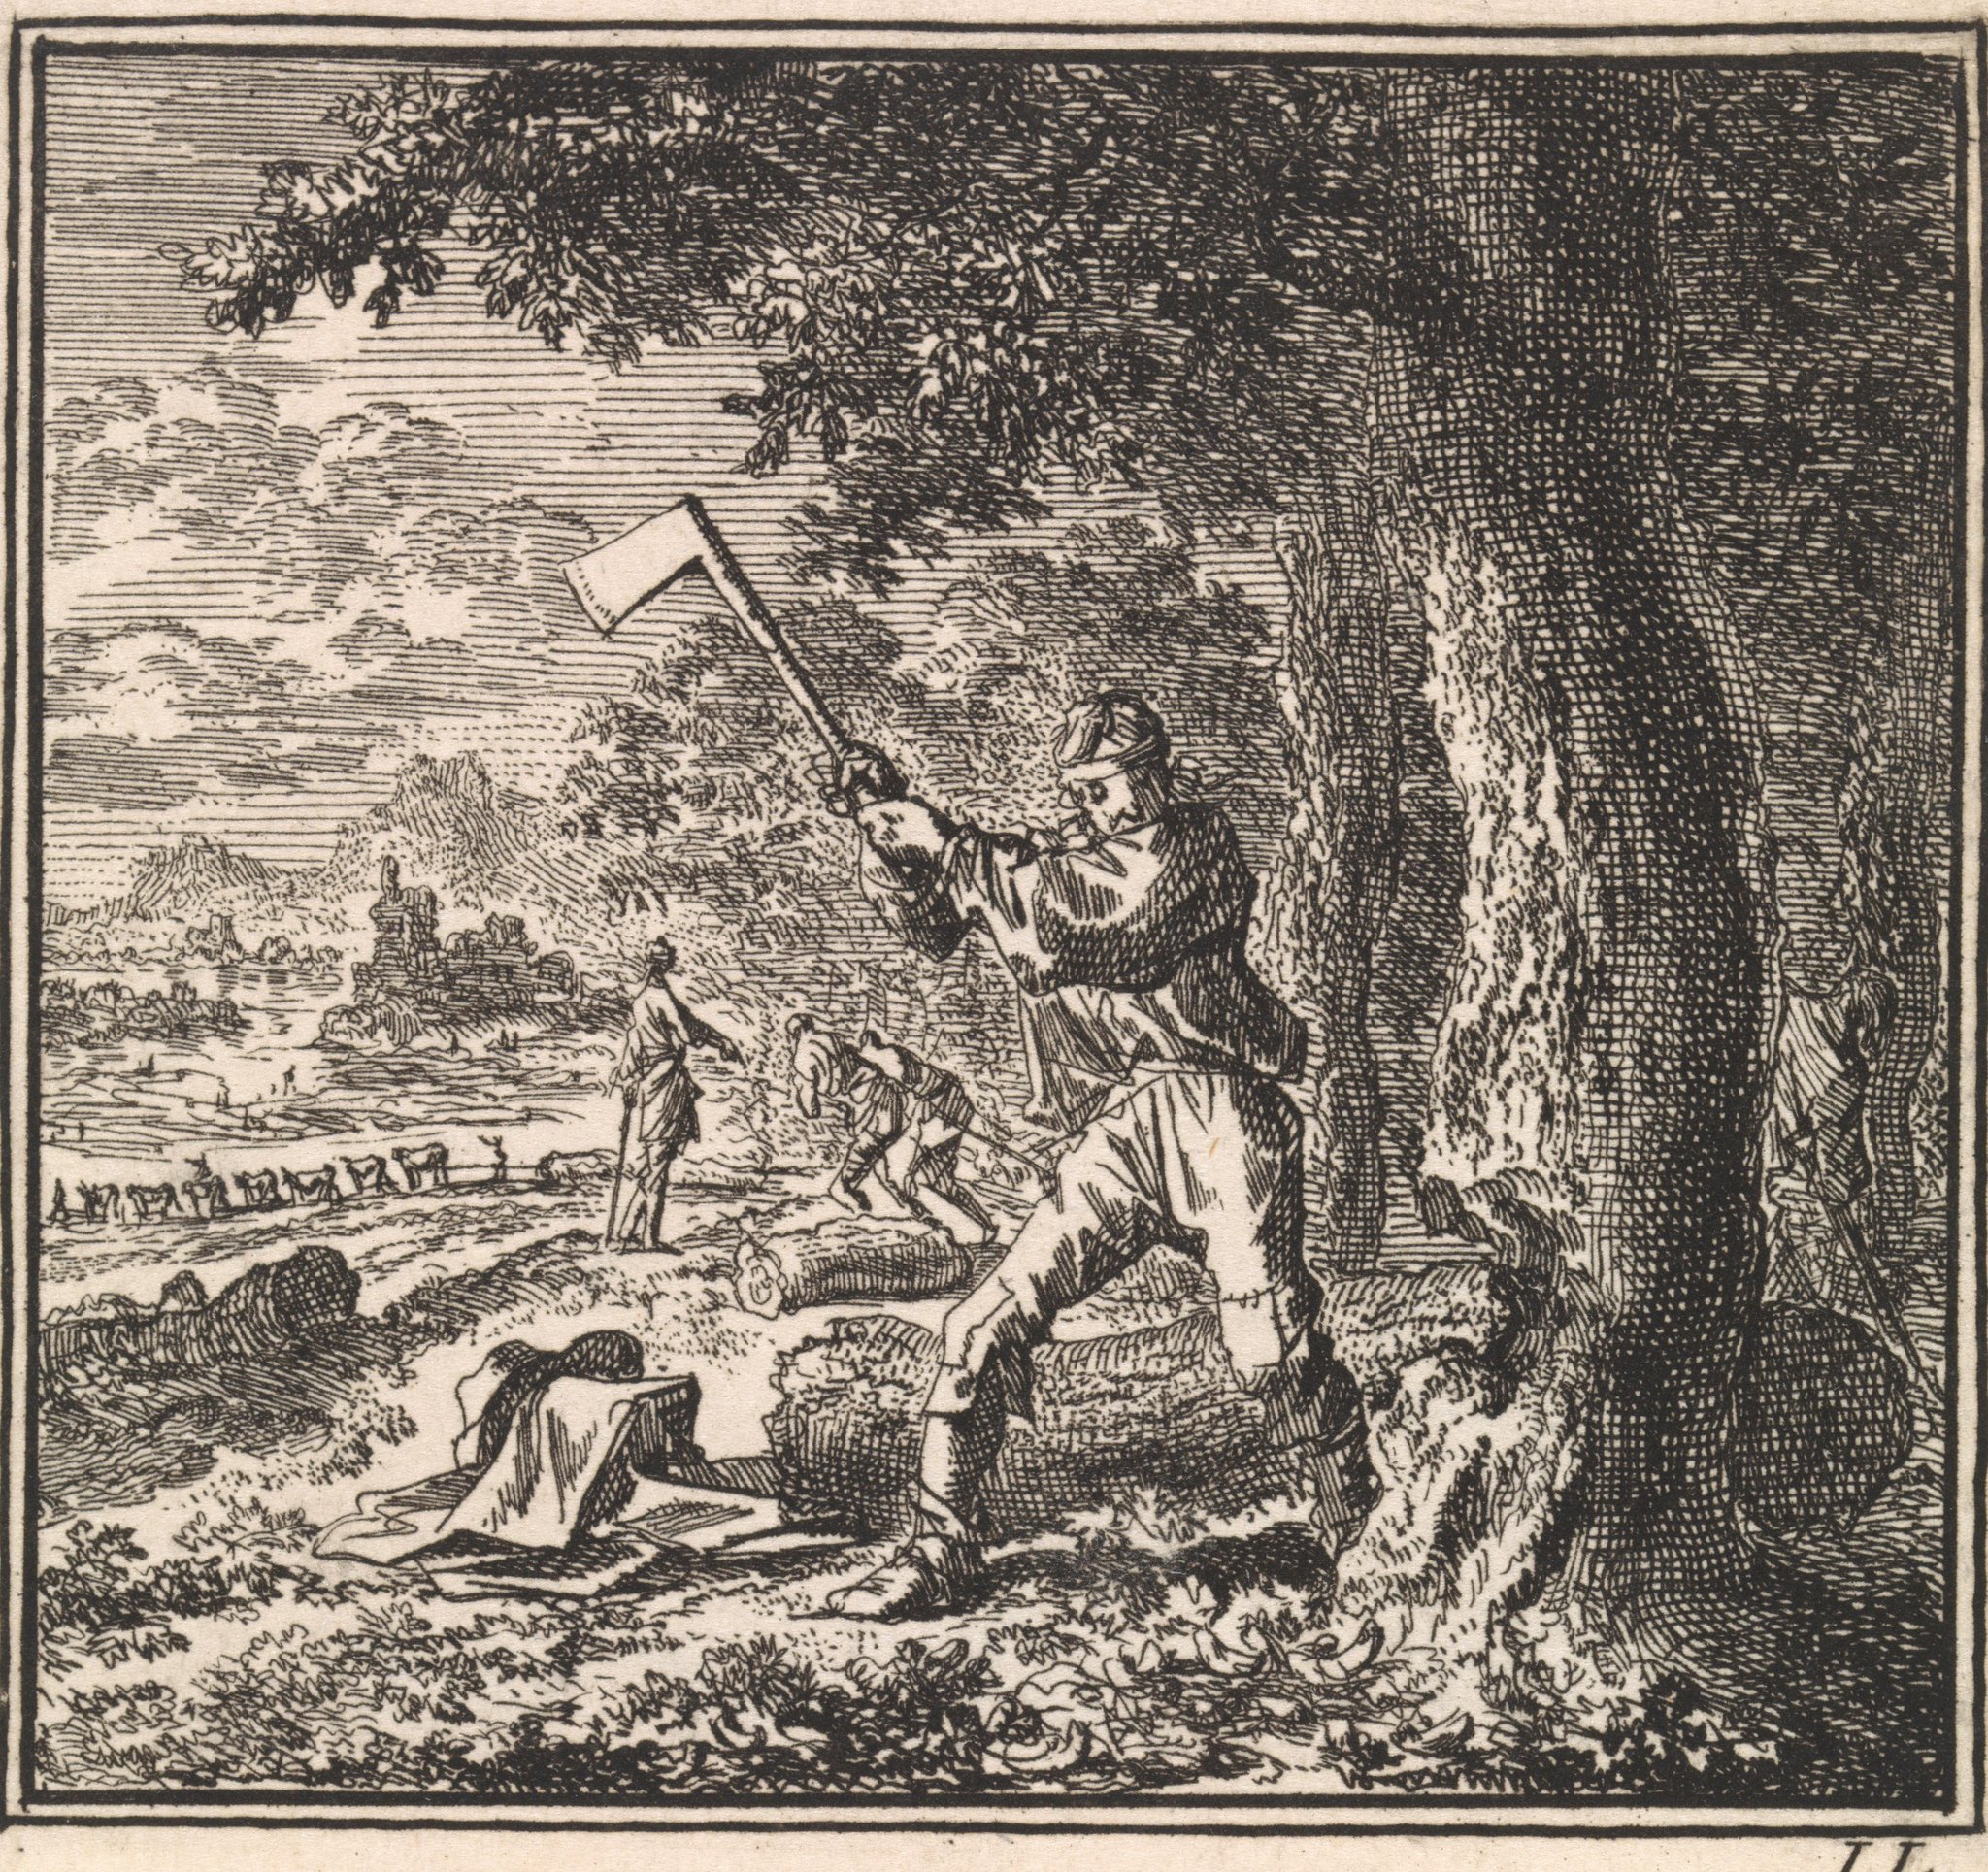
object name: book illustration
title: De Byl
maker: jan luyken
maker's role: draughtsman, print maker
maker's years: 1649-1712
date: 1711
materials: paper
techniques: etching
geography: amsterdam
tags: woodcutter, wood-engraver, tools, aids, implements ~ crafts and industries: axe, forest, wood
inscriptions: collector's mark: Lugt 2228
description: Illustratie voor: Luyken, Jan. De Bykorf des Gemoeds. Amsterdam: Pieter Arentsz. II (wed.) en Cornelis van der Sys, 1711, p. 266.